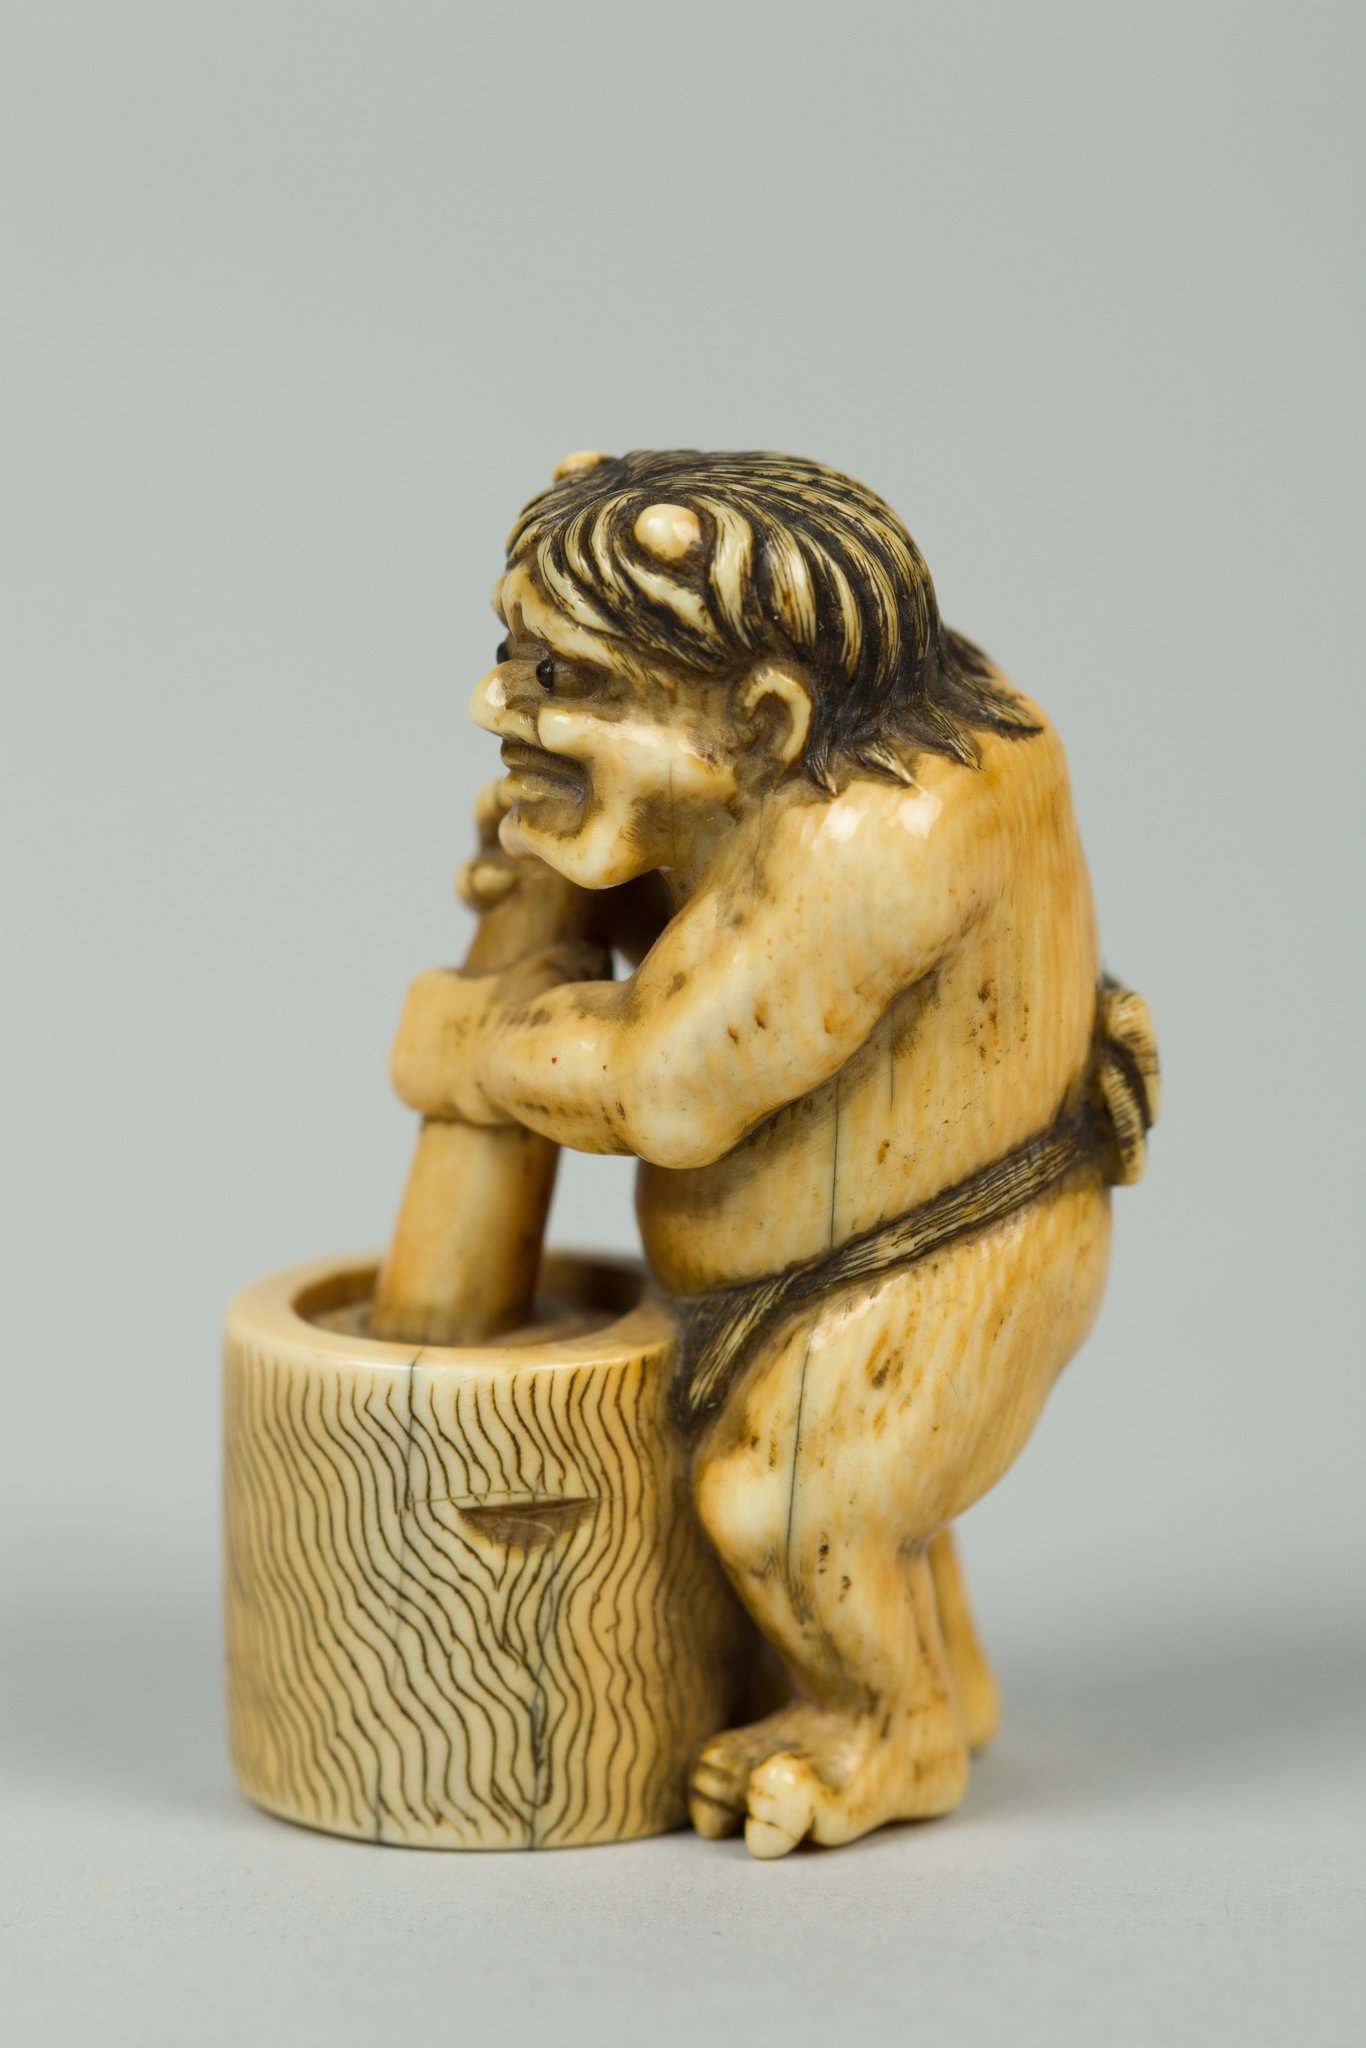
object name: netsuke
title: Netsuke of a Demon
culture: japanese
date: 1701-1800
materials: ivory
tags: demons